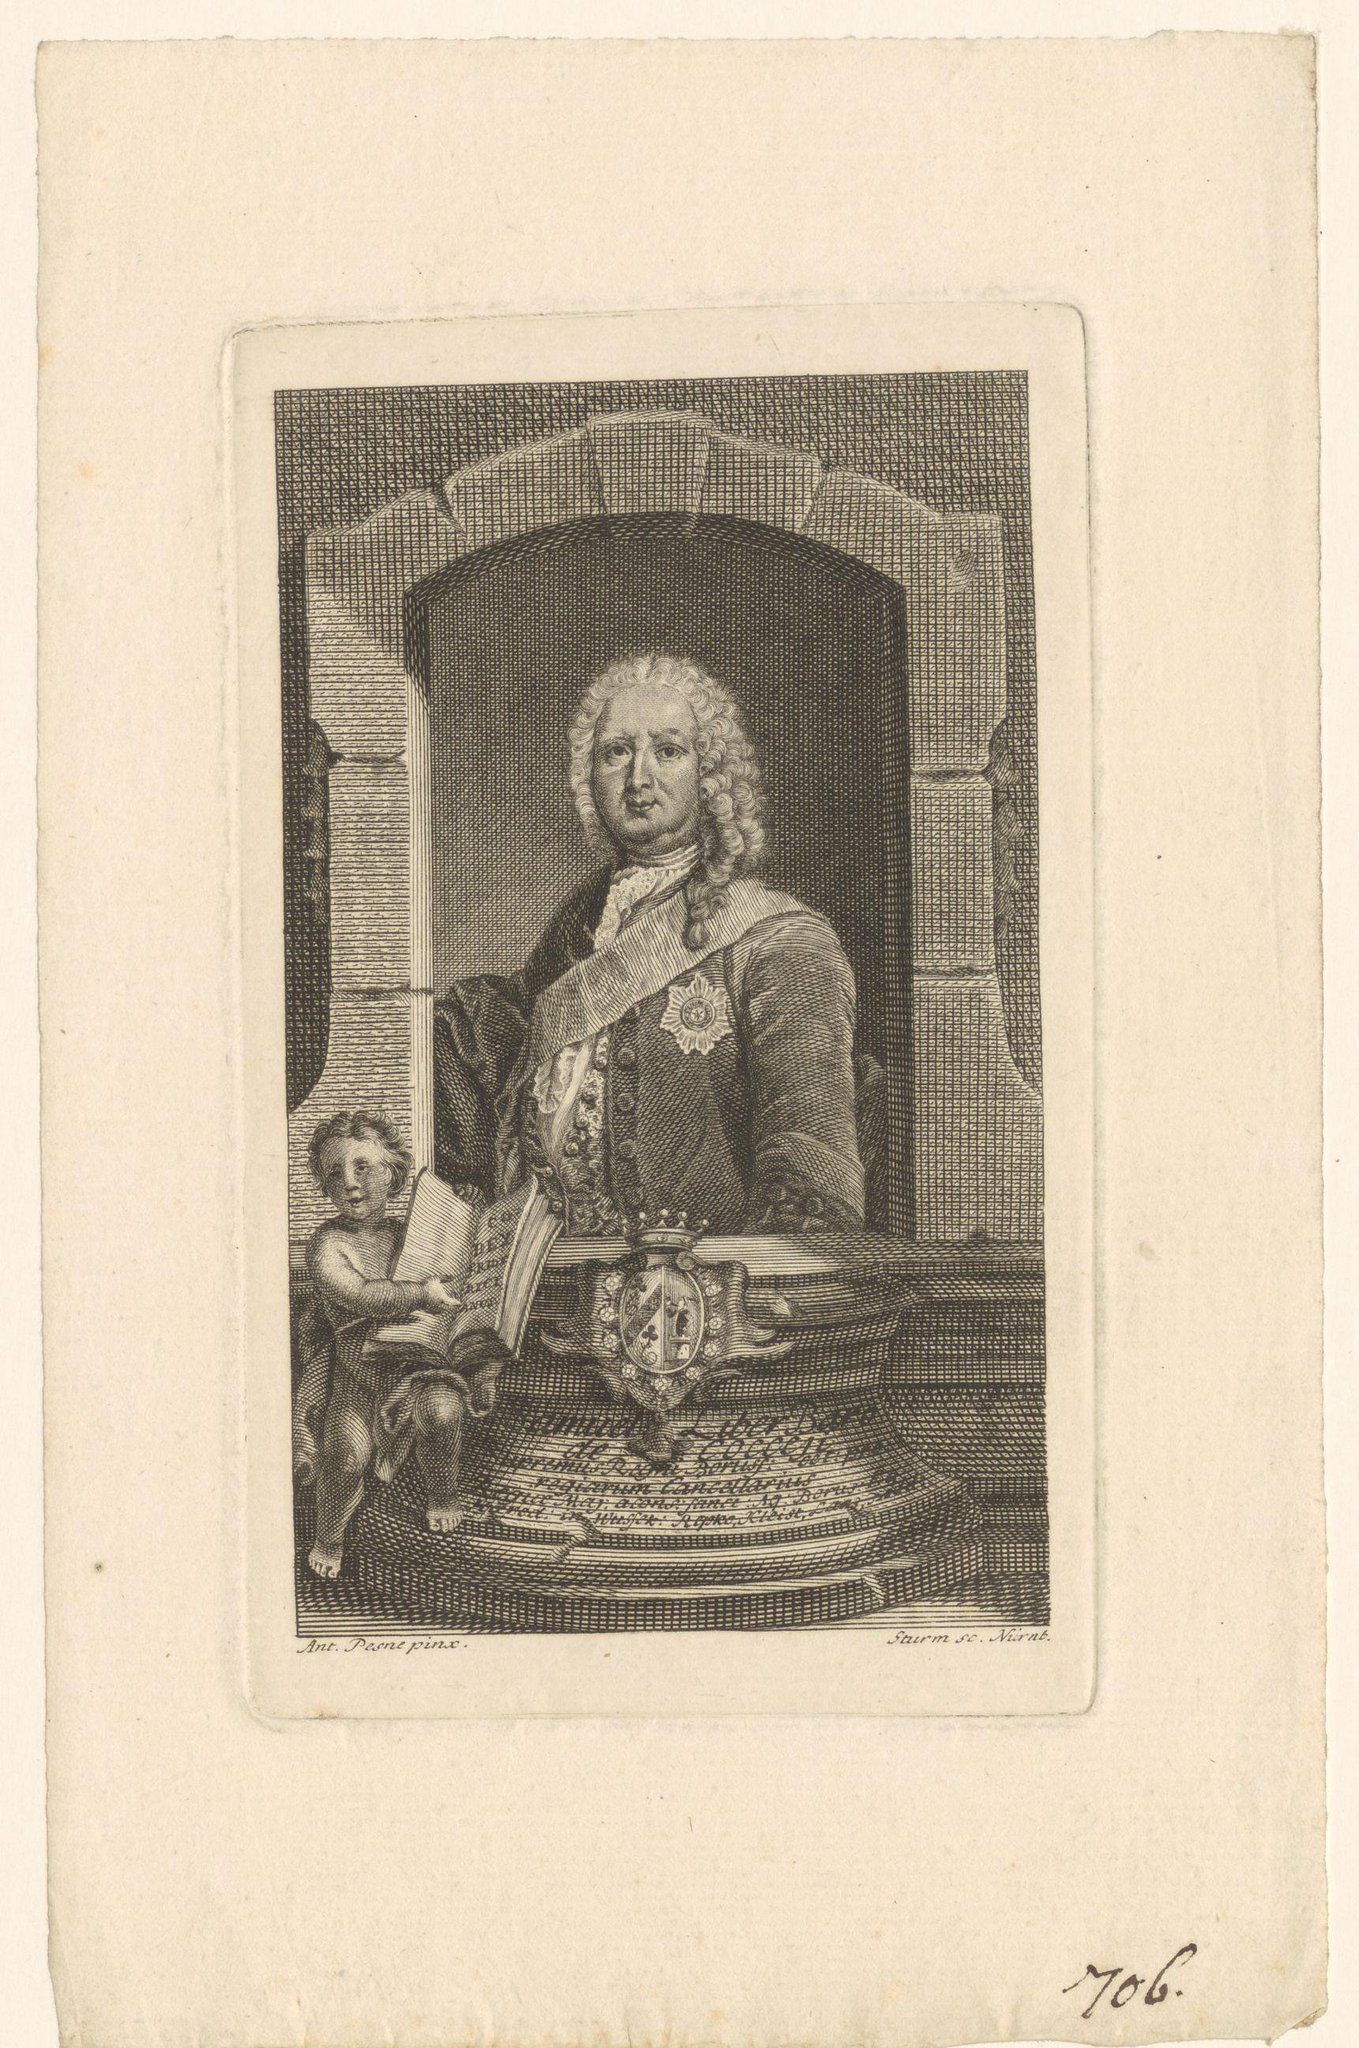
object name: print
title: Portret van Samuel, Freiherr von Cocceji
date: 1752-1793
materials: paper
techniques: engraving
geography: nuremberg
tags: berlin, historical persons, book, armorial bearing, heraldry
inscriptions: collector's mark: Lugt 2228, number: ‘706’